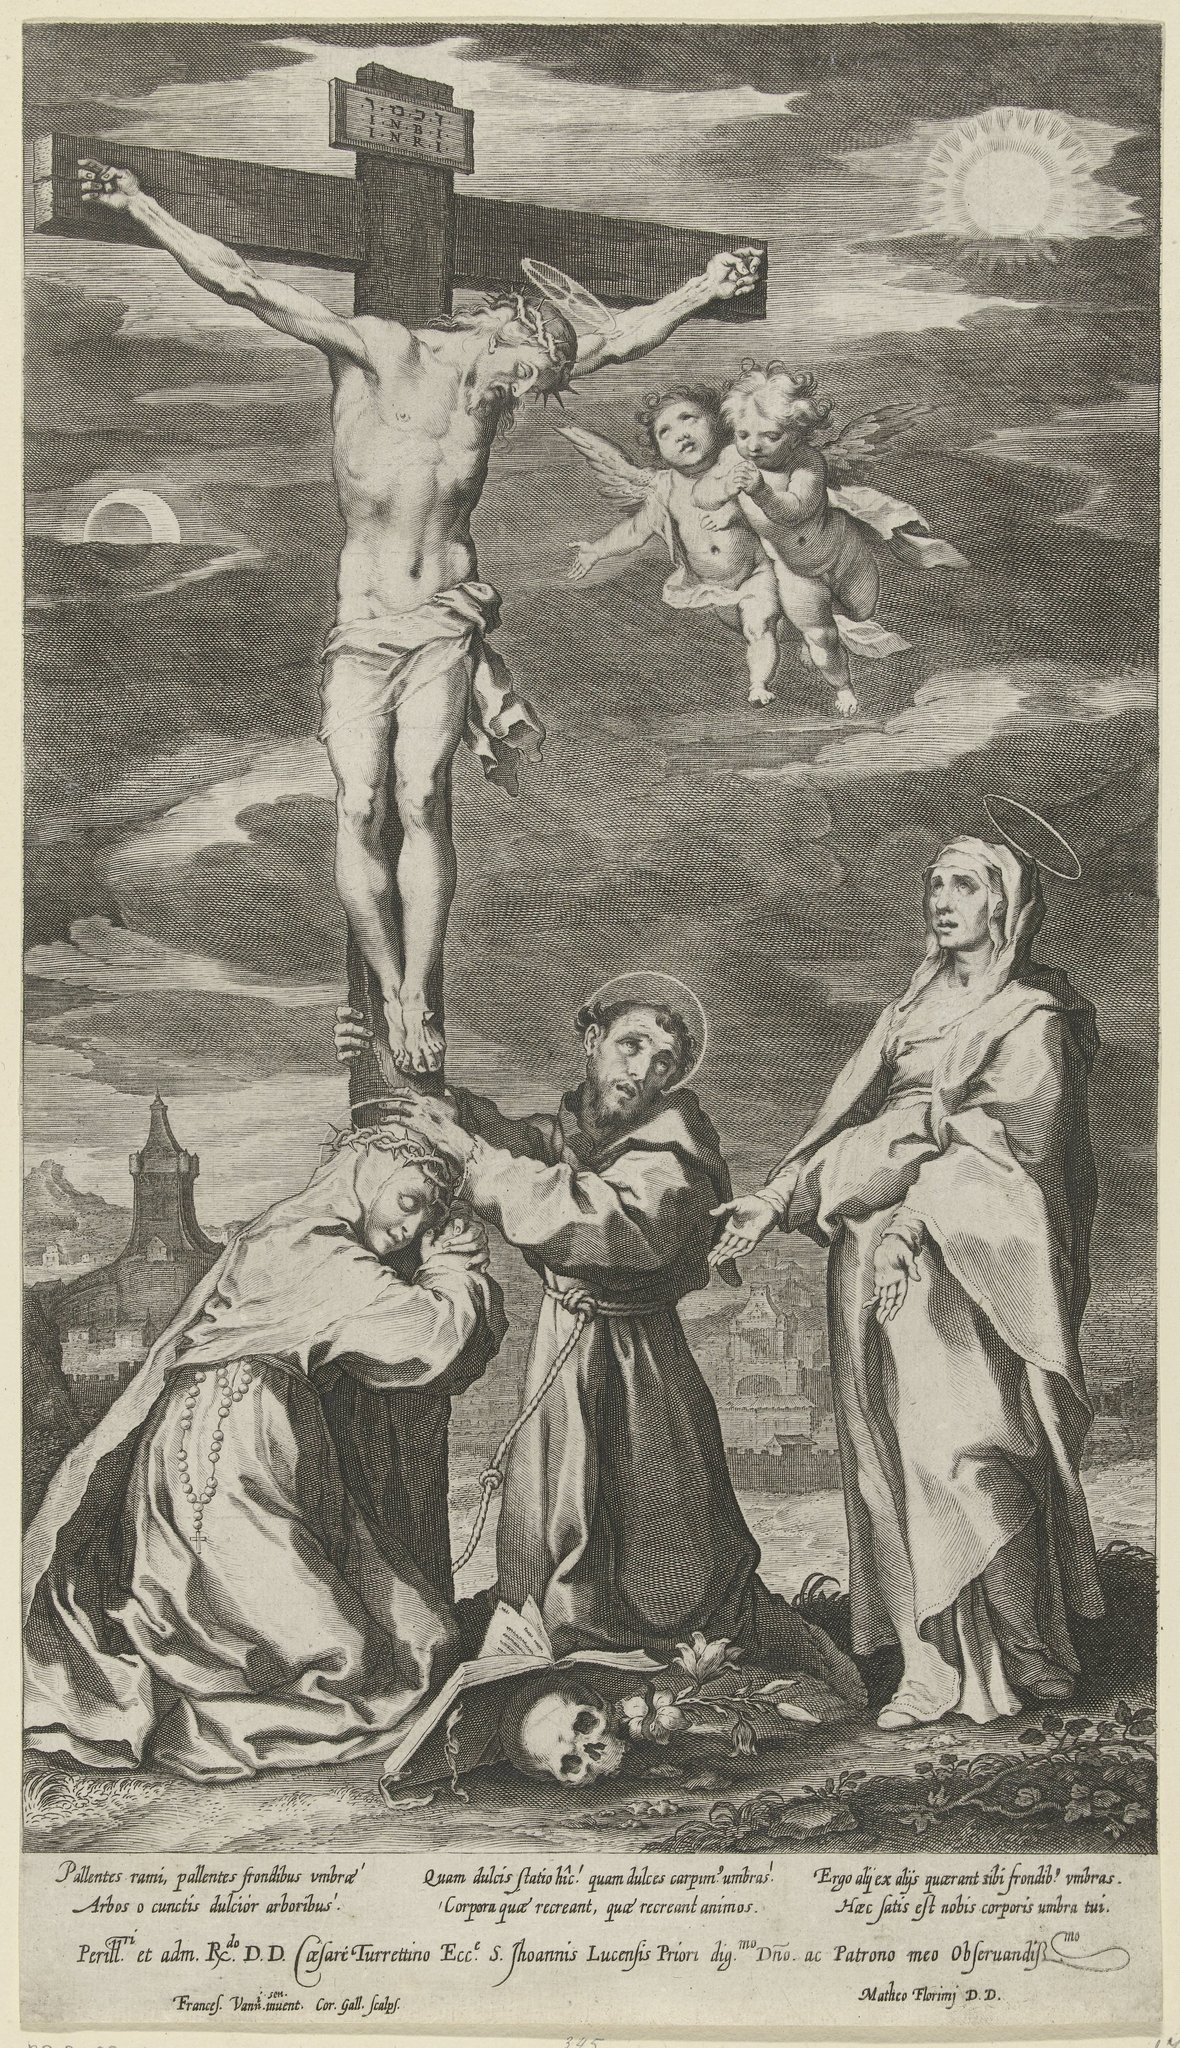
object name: print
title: Christus aan het kruis, met Maria, de H. Franciscus en de H. Catharina van Siena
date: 1590-1613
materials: paper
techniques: engraving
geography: siena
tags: the virgin and dominican tertiary, catherine of siena; possible attributes: book, cross, crown of thorns, crucifix, demon under foot, heart (with cross), lily, plague-stricken, ring, rosary, stigmata, founder of the order of friars minor (franciscans), francis(cus) of assisi; possible attributes: book, crucifix, lily, skull, stigmata, crucified christ with stephaton and/or longinus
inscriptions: collector's mark: Lugt 240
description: Christus hangt aan het kruis, aan de voeten van het kruis knielen Catharina van Siena en Franciscus. Voor hen ligt een opengeslagen boek, een schedel en een lelietak. Naast het kruis staat Maria. Ze toont haar handpalmen en blikt richting hemel. Aan weerszijden van het kruis de zon en de maand. Onder de voorstelling een Latijns vers.